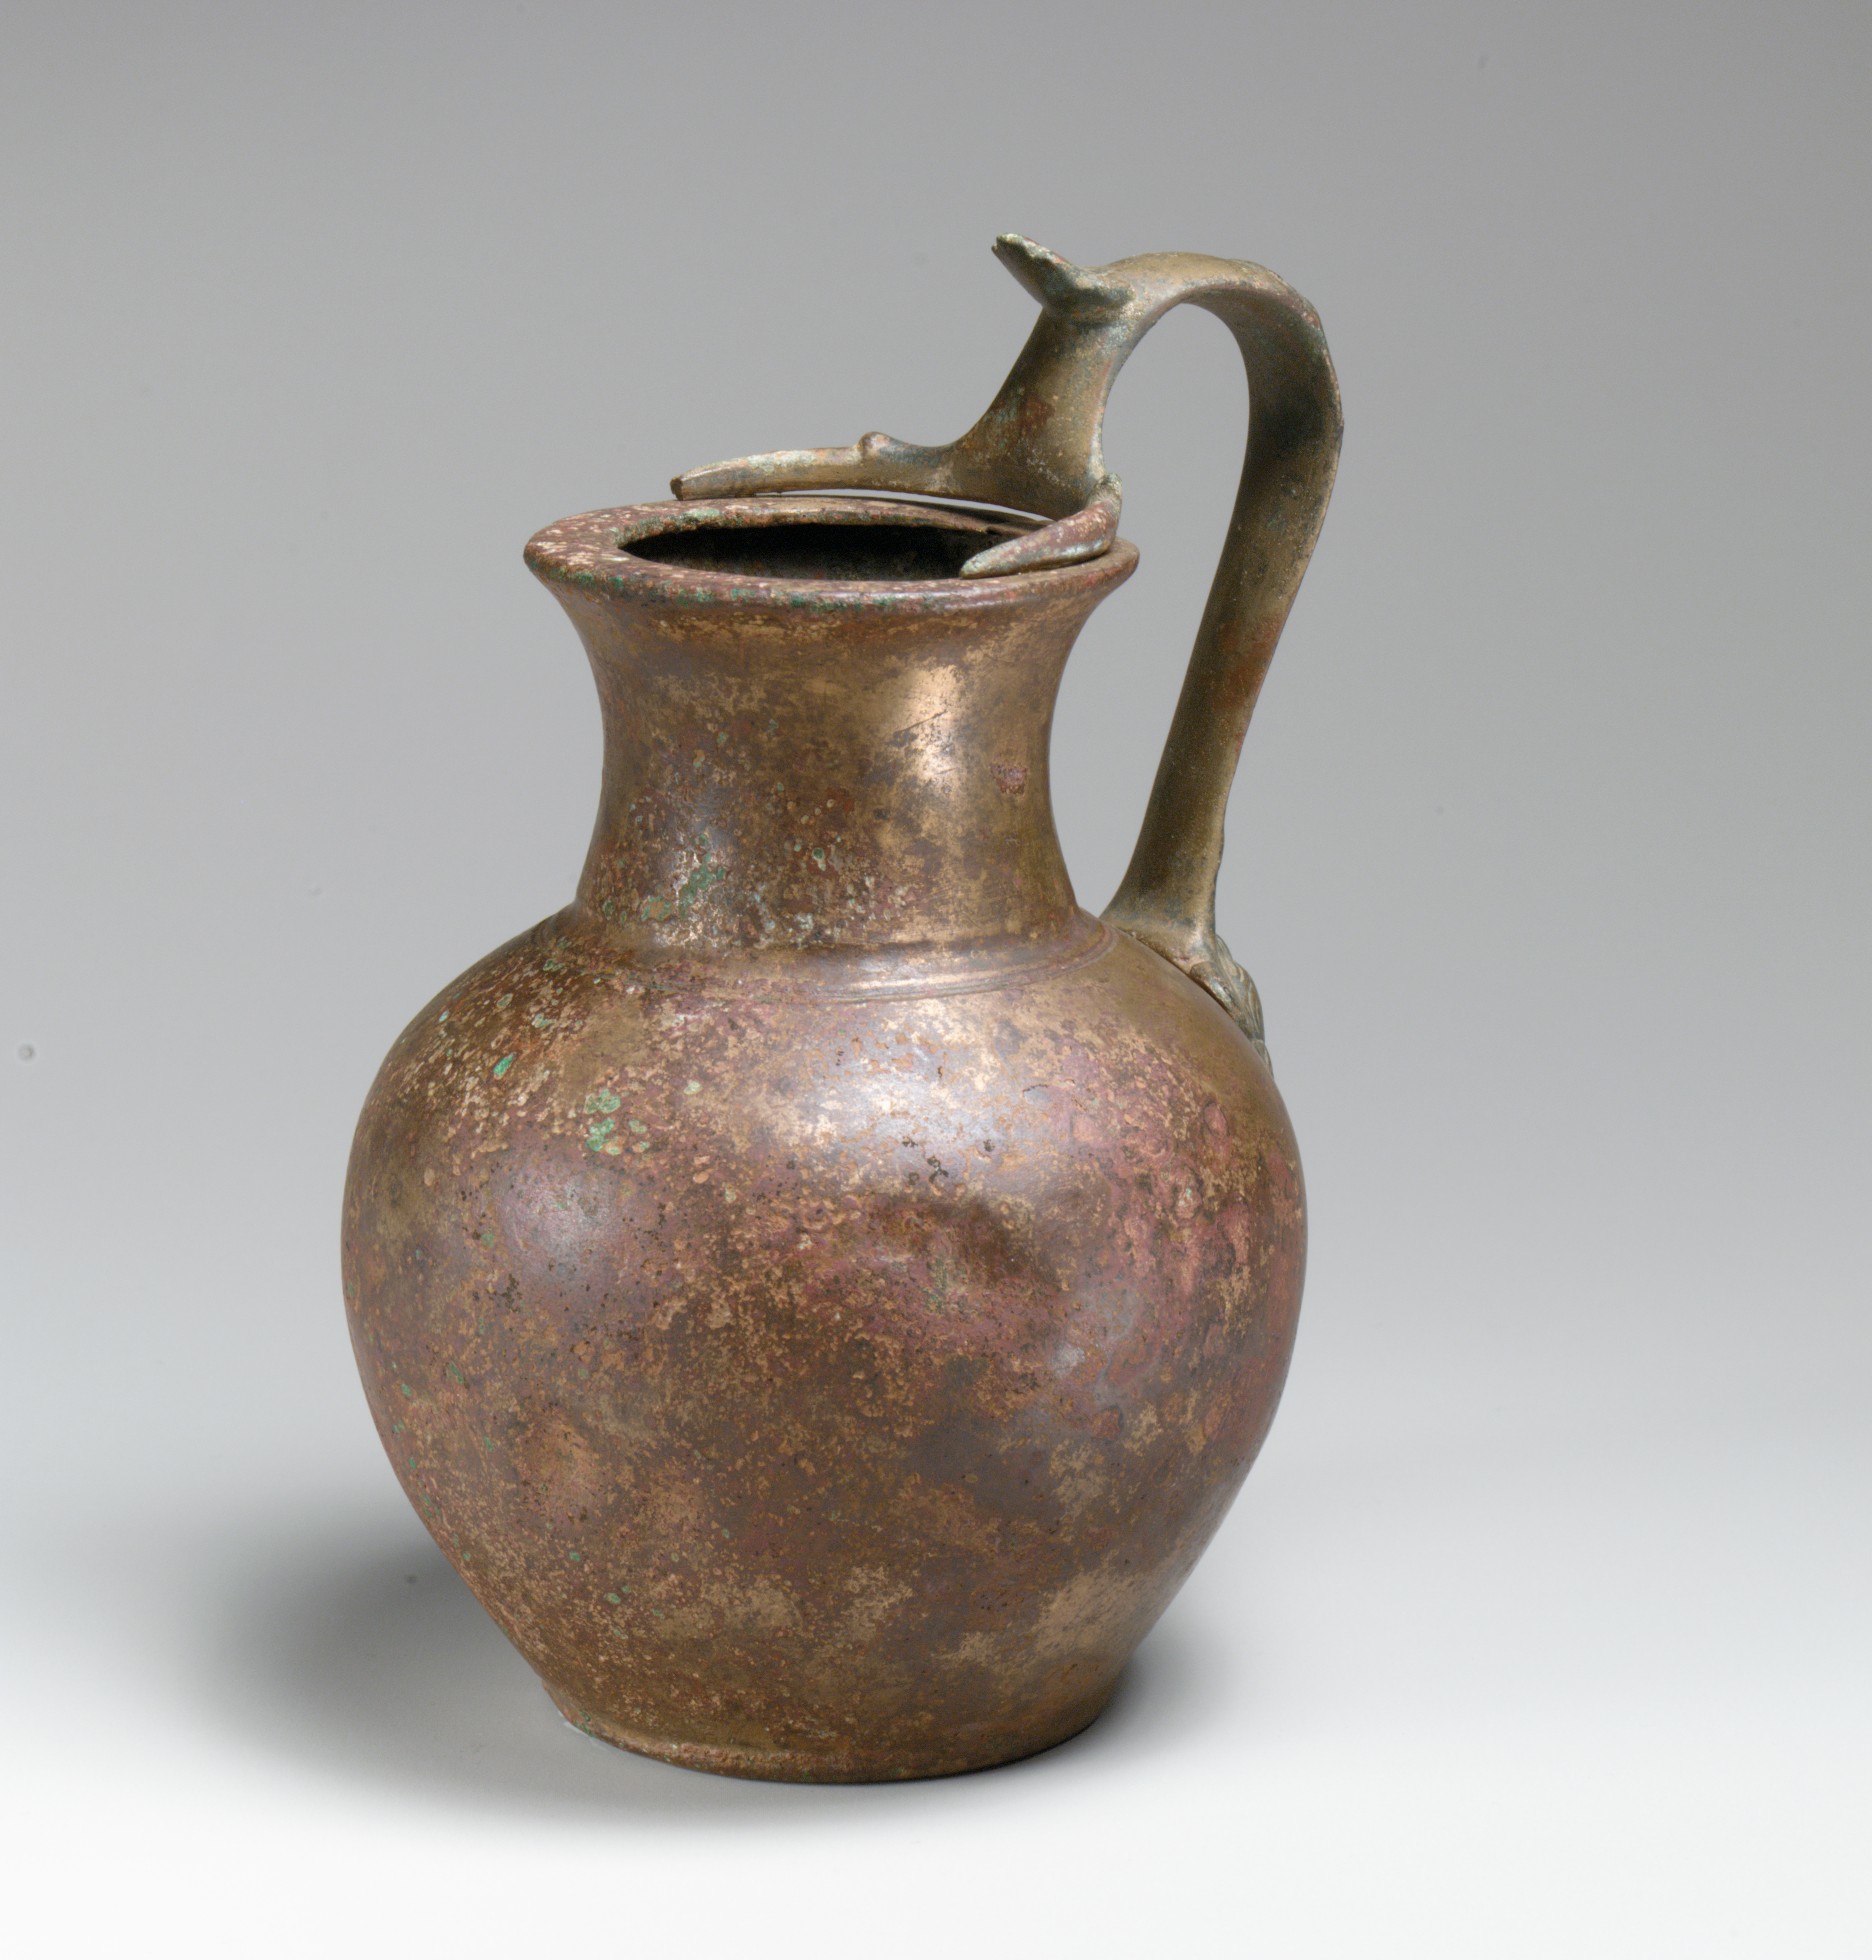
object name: jug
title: Bronze jug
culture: roman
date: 67-200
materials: bronze